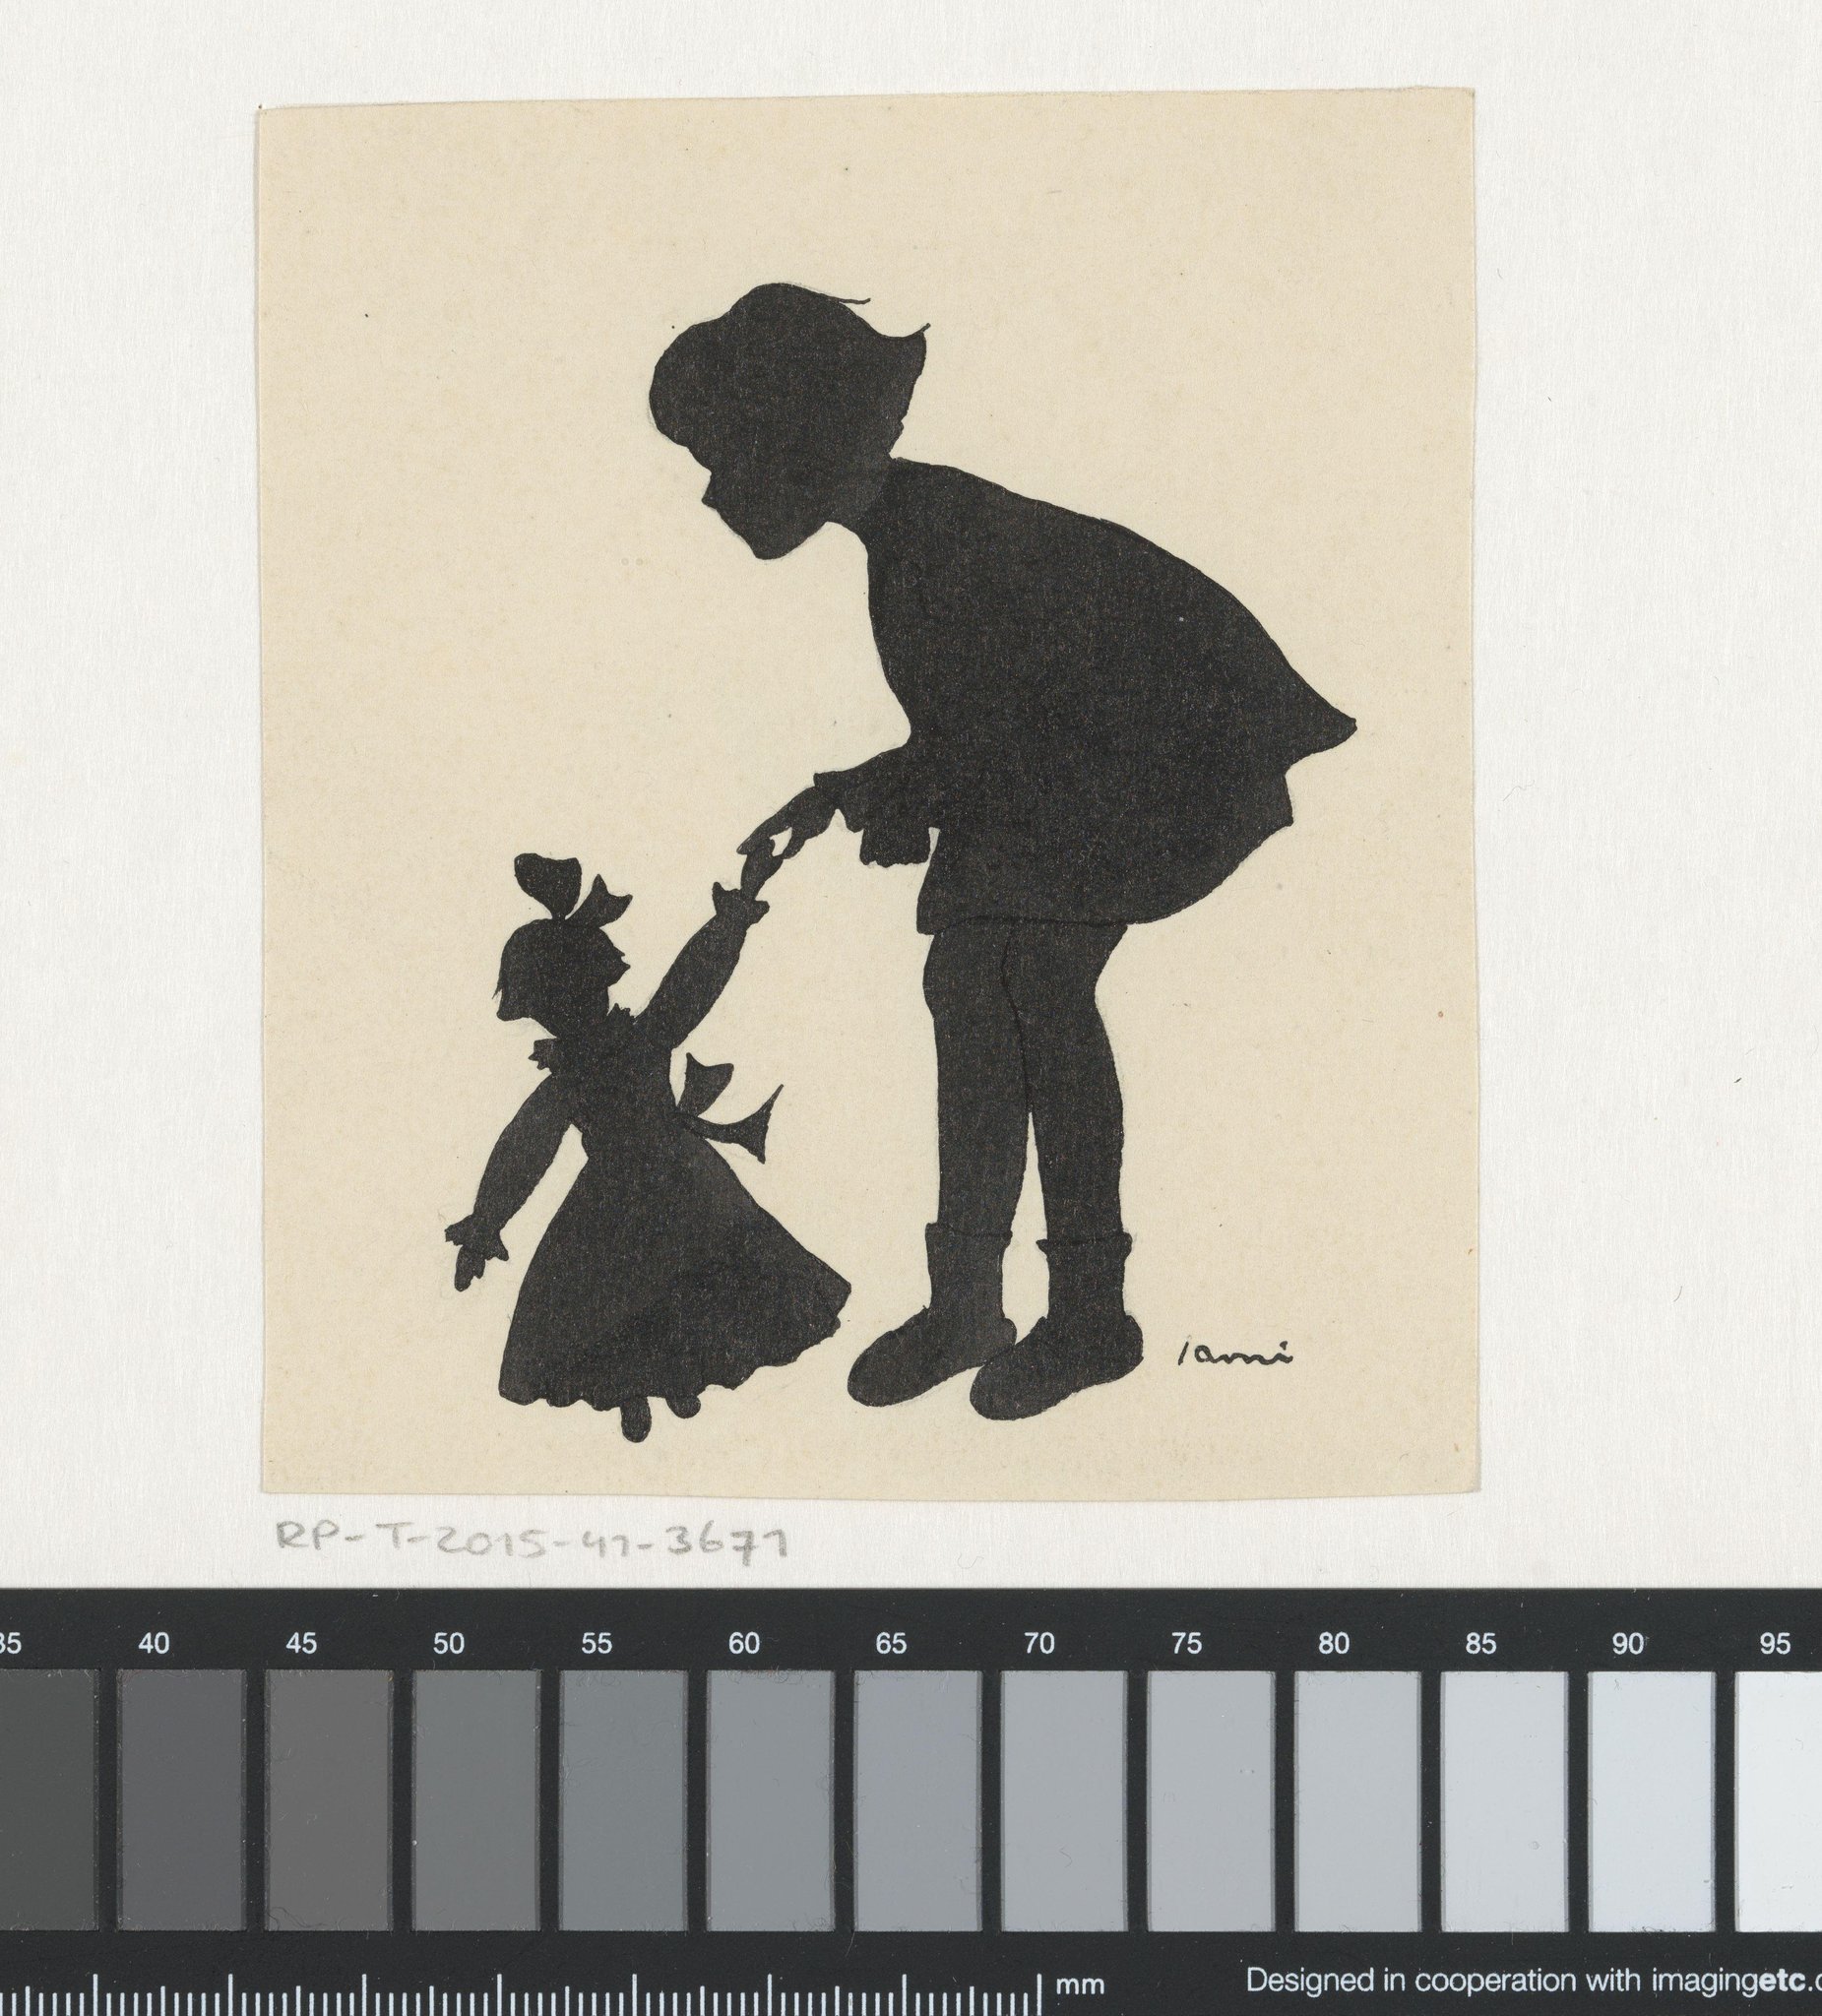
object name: boekillustratie ontwerp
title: Meisje met een pop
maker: Anonymous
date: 1880-1930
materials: ink, paper, pencil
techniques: brush, pen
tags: (playing with) dolls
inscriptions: annotation: ‘Juni IV/ Zusje en haar Popje’, collector's mark: Lugt 2228a, :, signature: ‘lami’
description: Een meisje houdt een pop bij de hand vast.